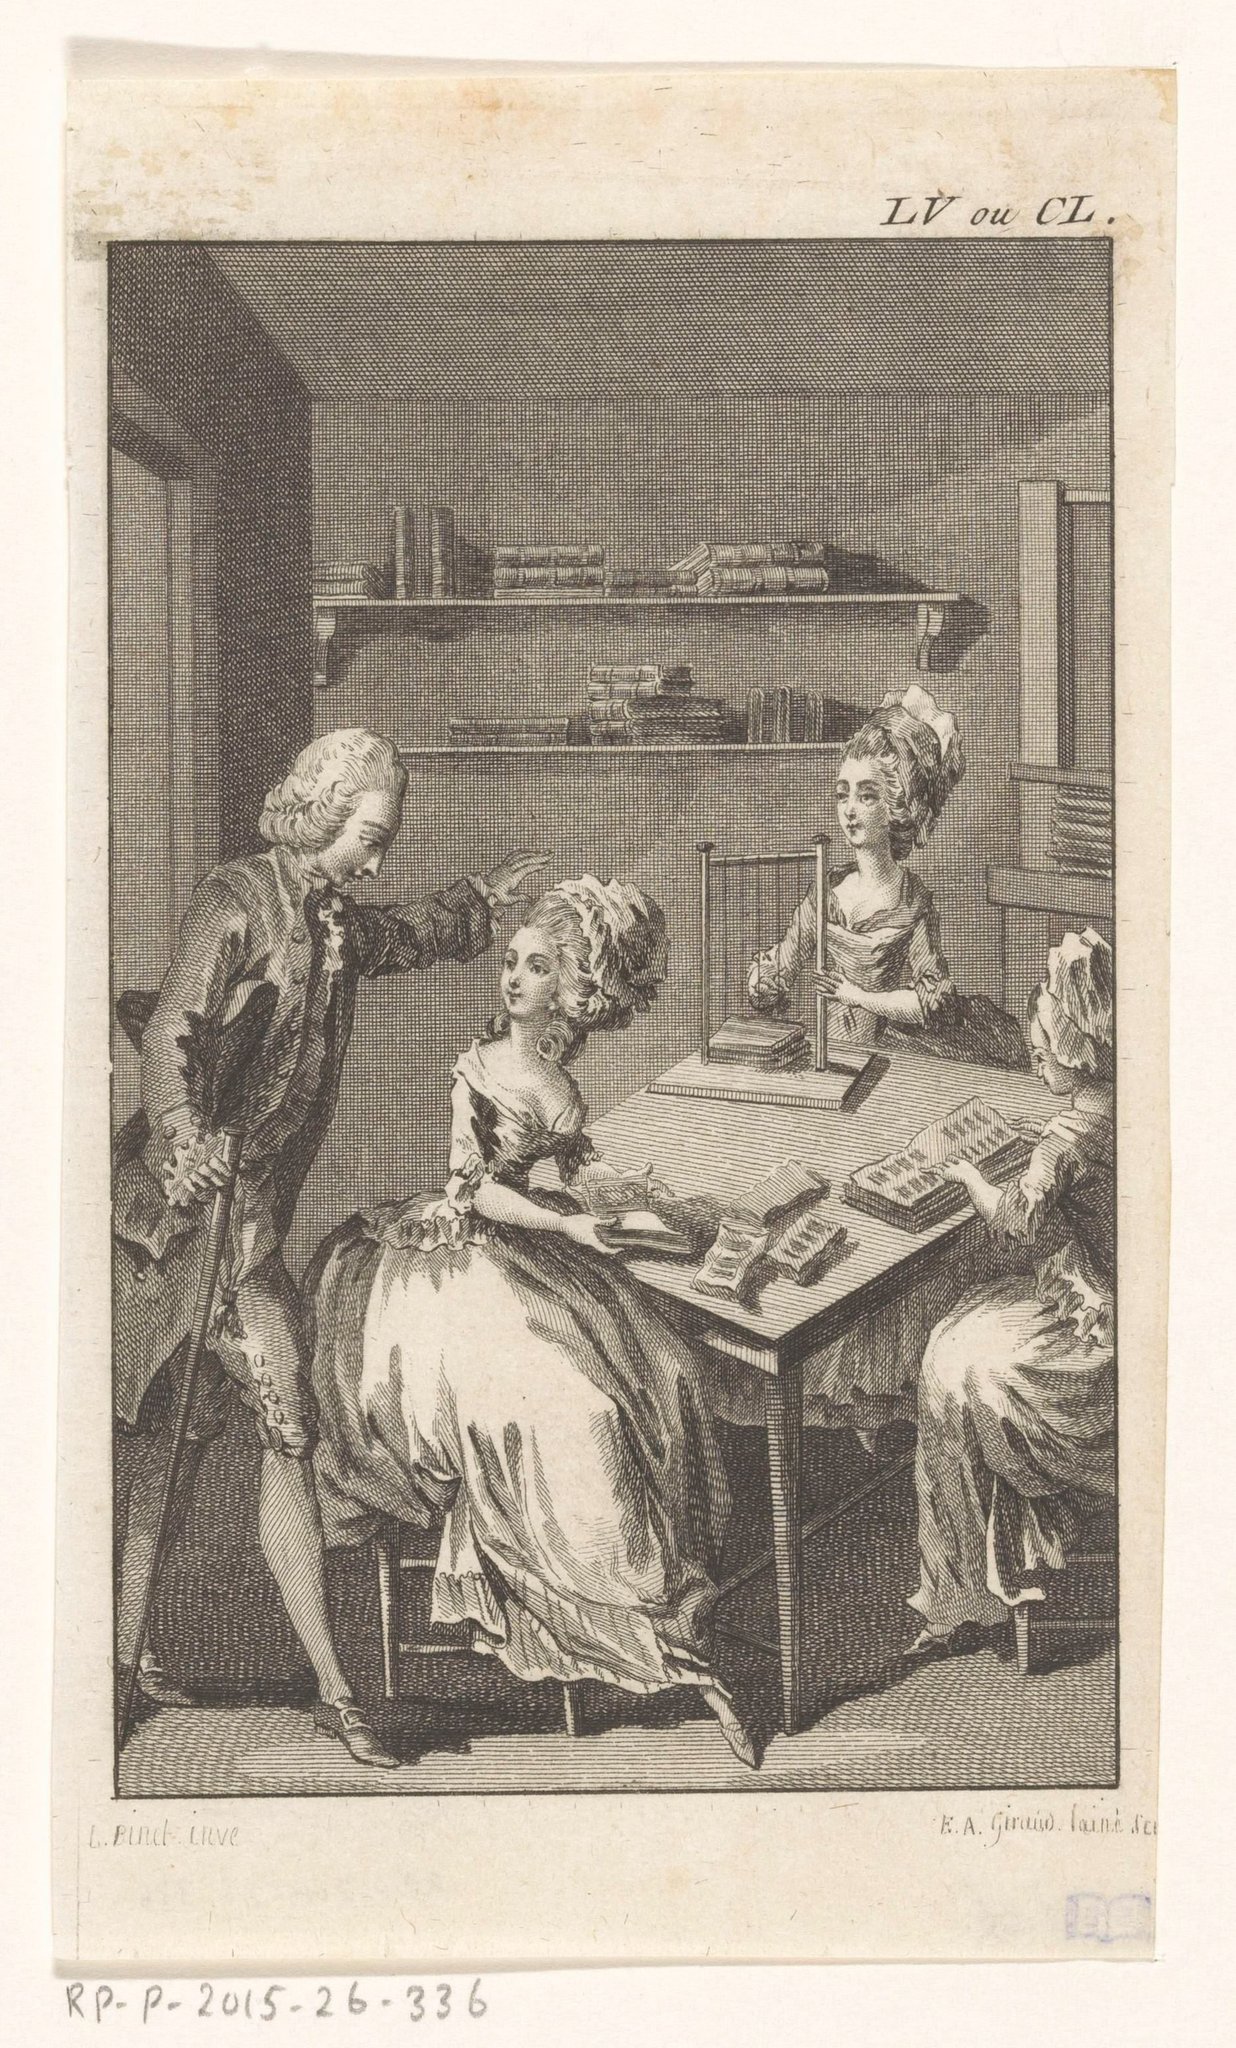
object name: book illustration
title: Boekbindsters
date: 1780-1785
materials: paper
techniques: etching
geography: leipzig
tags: bookbinding, handicrafts, craftsman at work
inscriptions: collector's mark: Lugt 4780, collector's mark: Lugt 4779, collector's mark: Lugt 2228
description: Interieur met drie vrouwen die aan een tafel katernen binden terwijl er een man met een stok komt binnenlopen. Aan de wand twee planken met boeken. De prent illustreert een verhaal van Nicolas Anne Edmé Restif de la Bretonne. Rechtsboven genummerd: LV ou Cl.